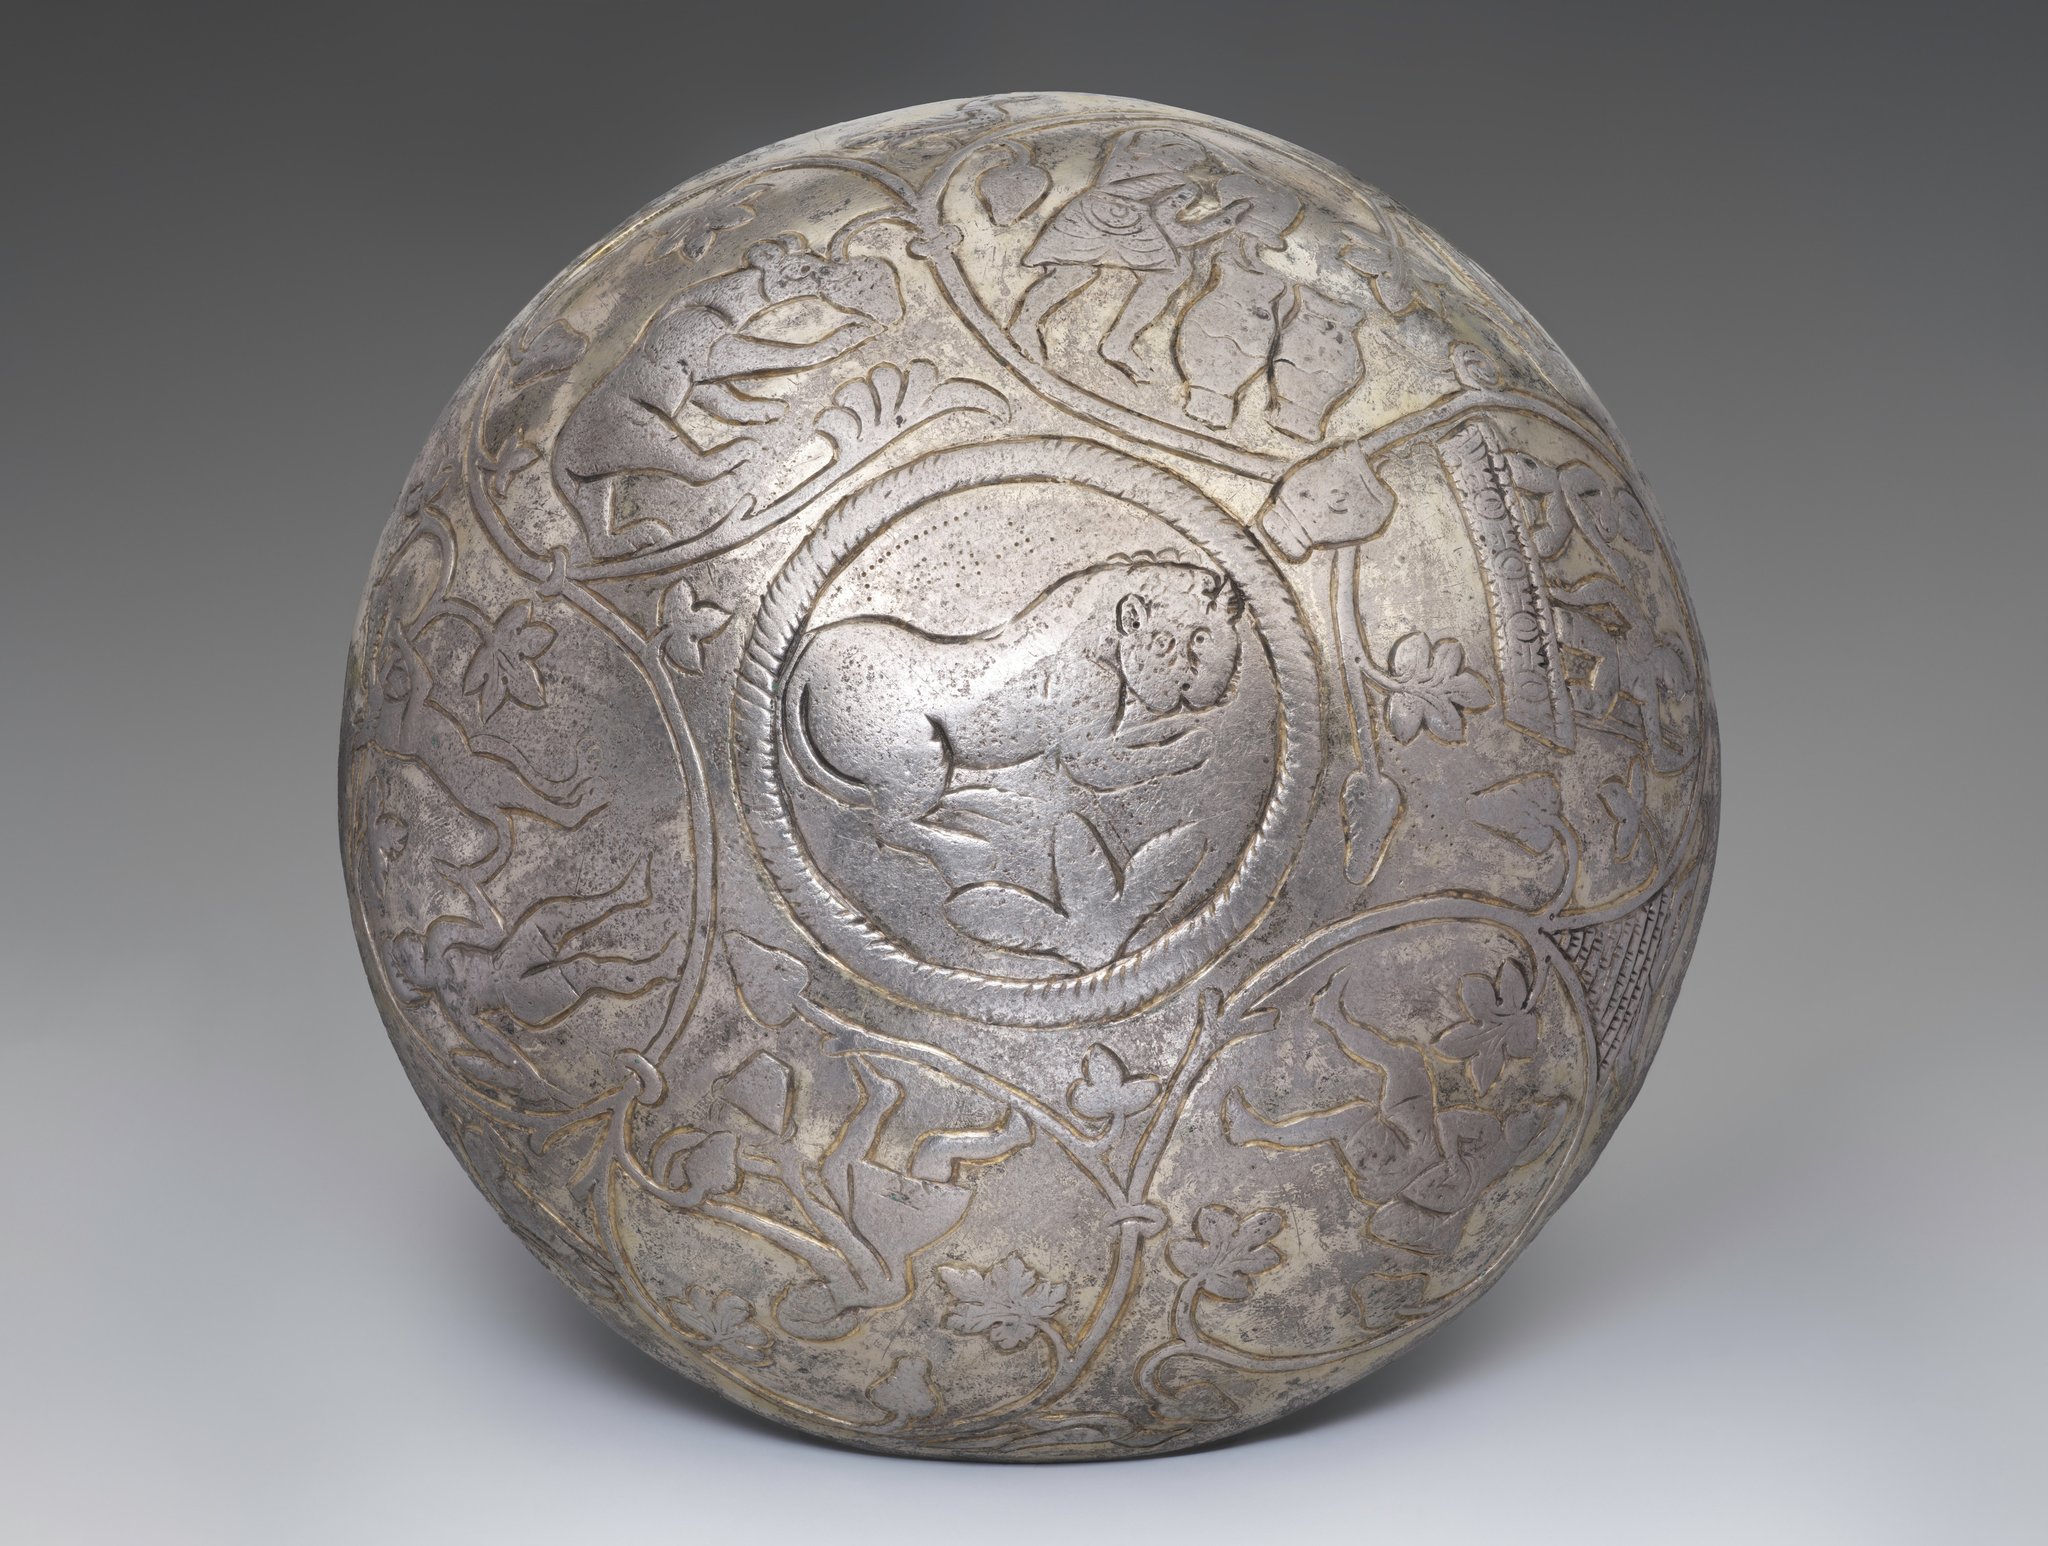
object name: bowl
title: Hemispherical bowl with scenes of wine making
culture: sasanian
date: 501-700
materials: mercury, silver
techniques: gilding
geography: iran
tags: bears,birds,fruit,wine,men